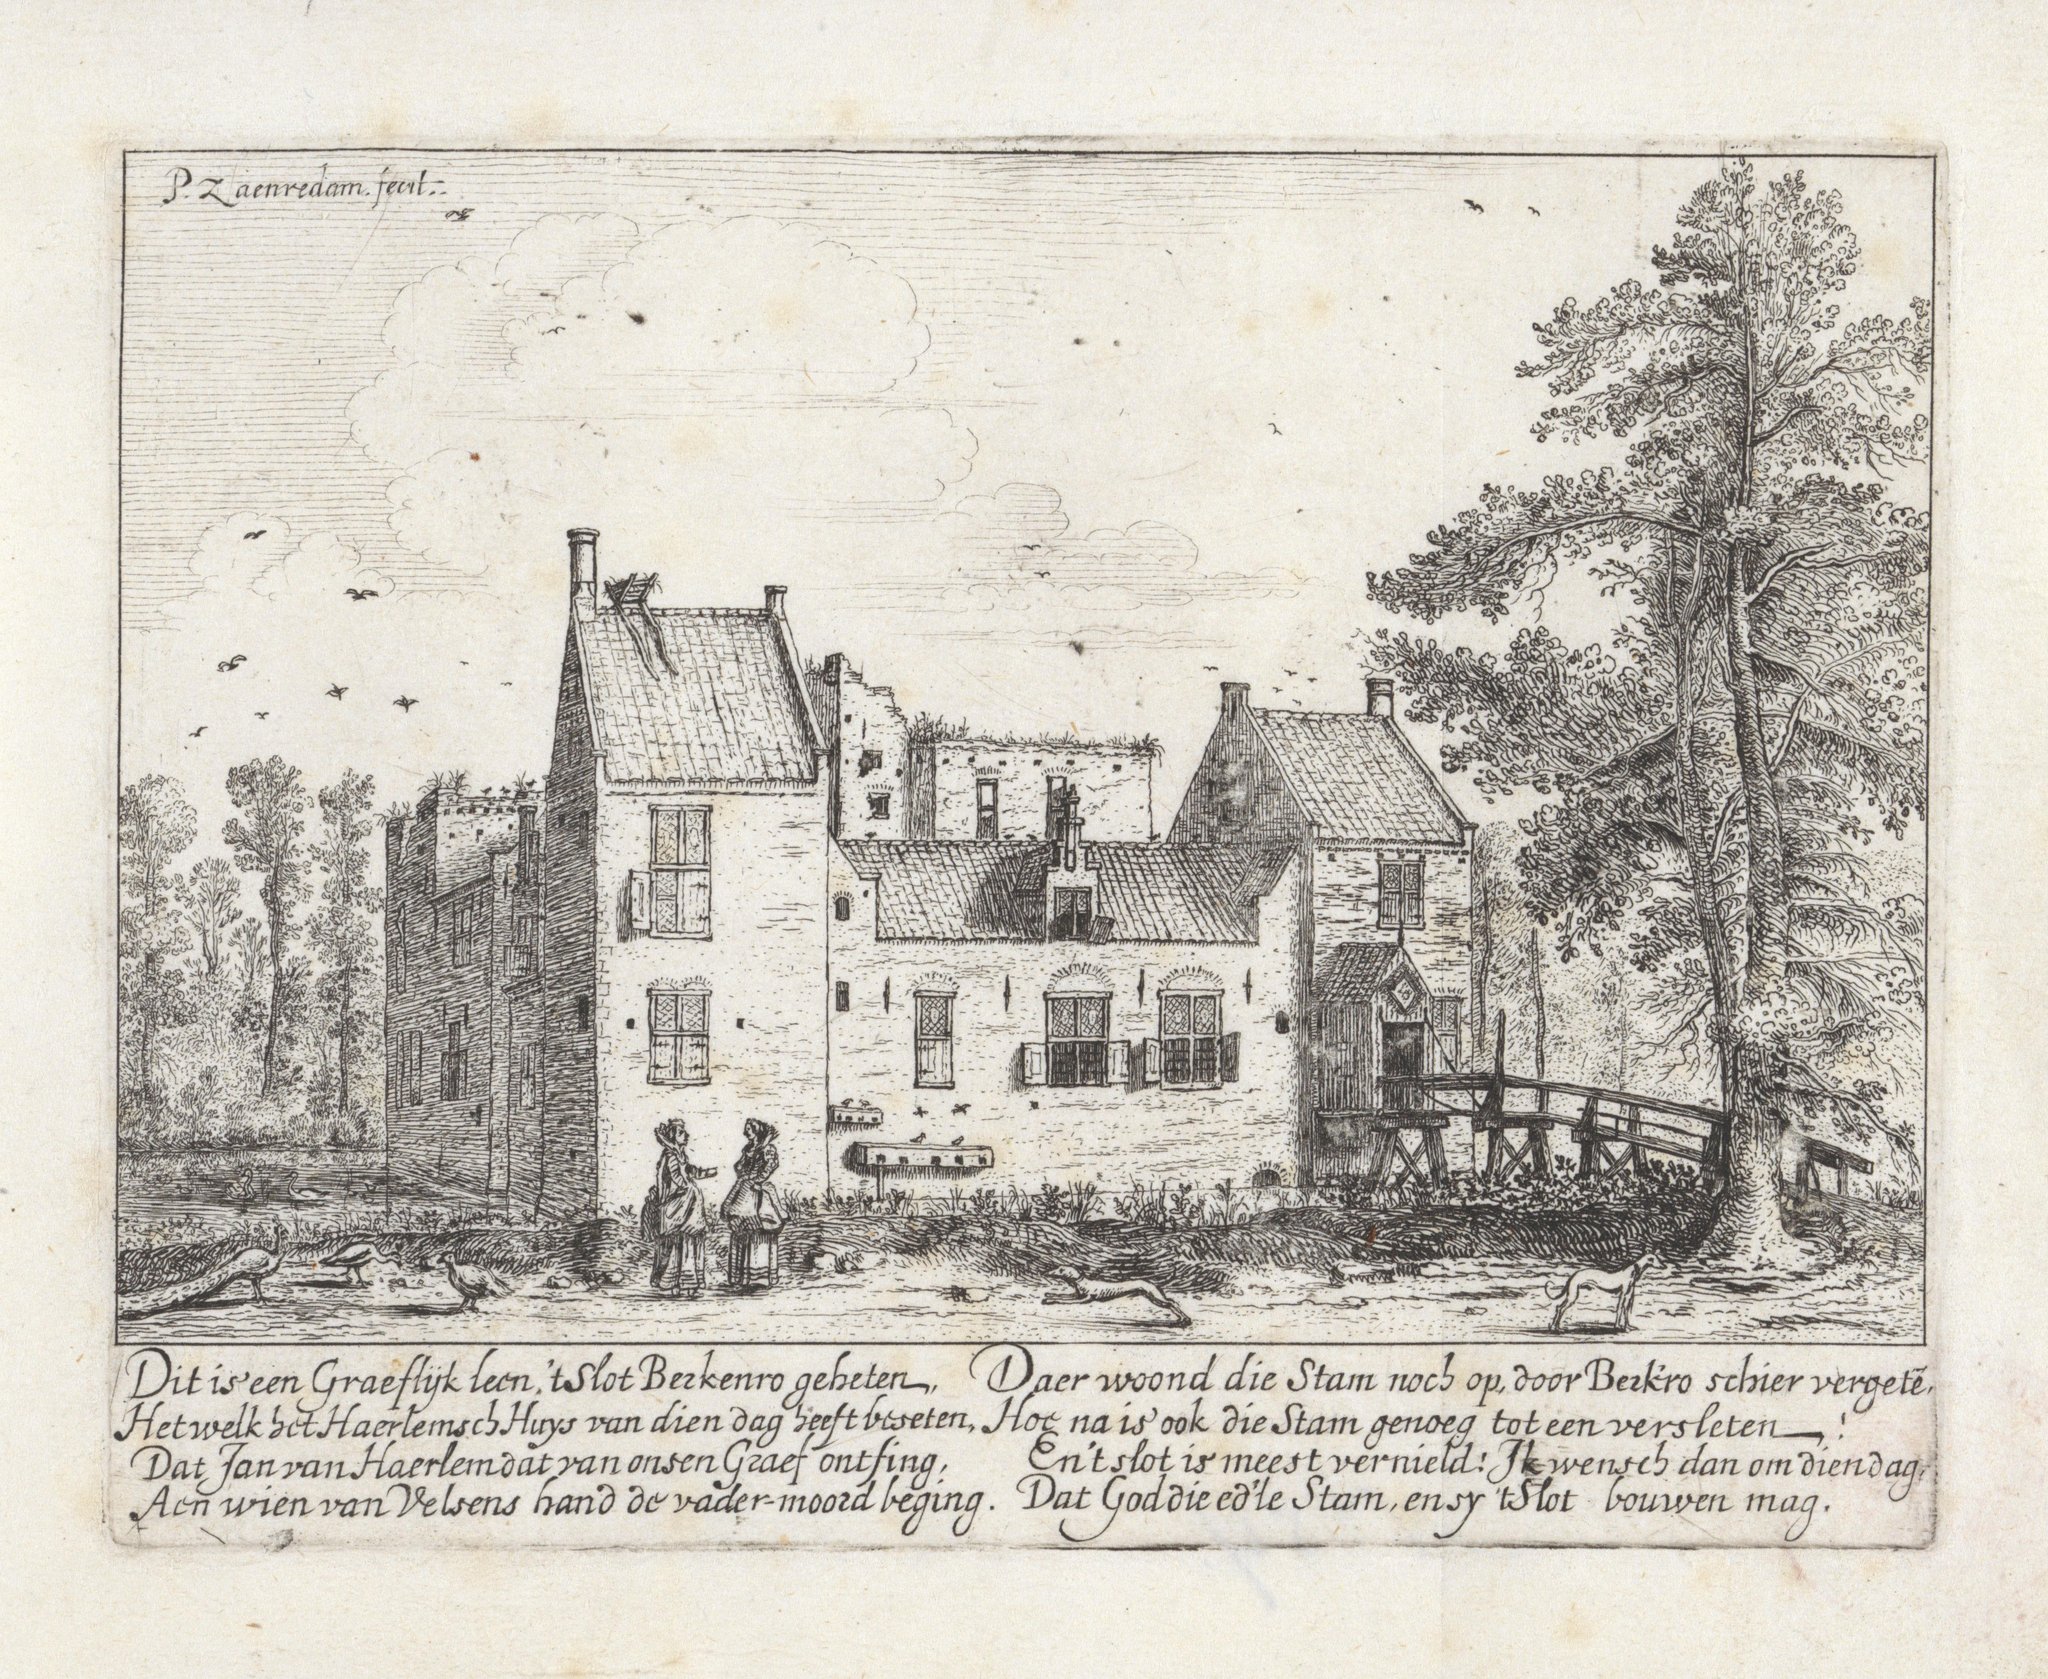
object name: print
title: Gezicht op Slot Berkenrode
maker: pieter jansz saenredam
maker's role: draughtsman, painter, print maker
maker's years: 1597-1665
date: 1628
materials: paper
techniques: etching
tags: castle, conversation, dialogue; conversation piece, dog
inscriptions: collector's mark: Lugt 240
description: Gezicht op Slot Berkenrode, nabij Haarlem. Op de voorgrond voeren twee vrouwen een gesprek en rechts staat een man, waar twee honden op af rennen. In de marge een korte geschiedenis van het kasteel.